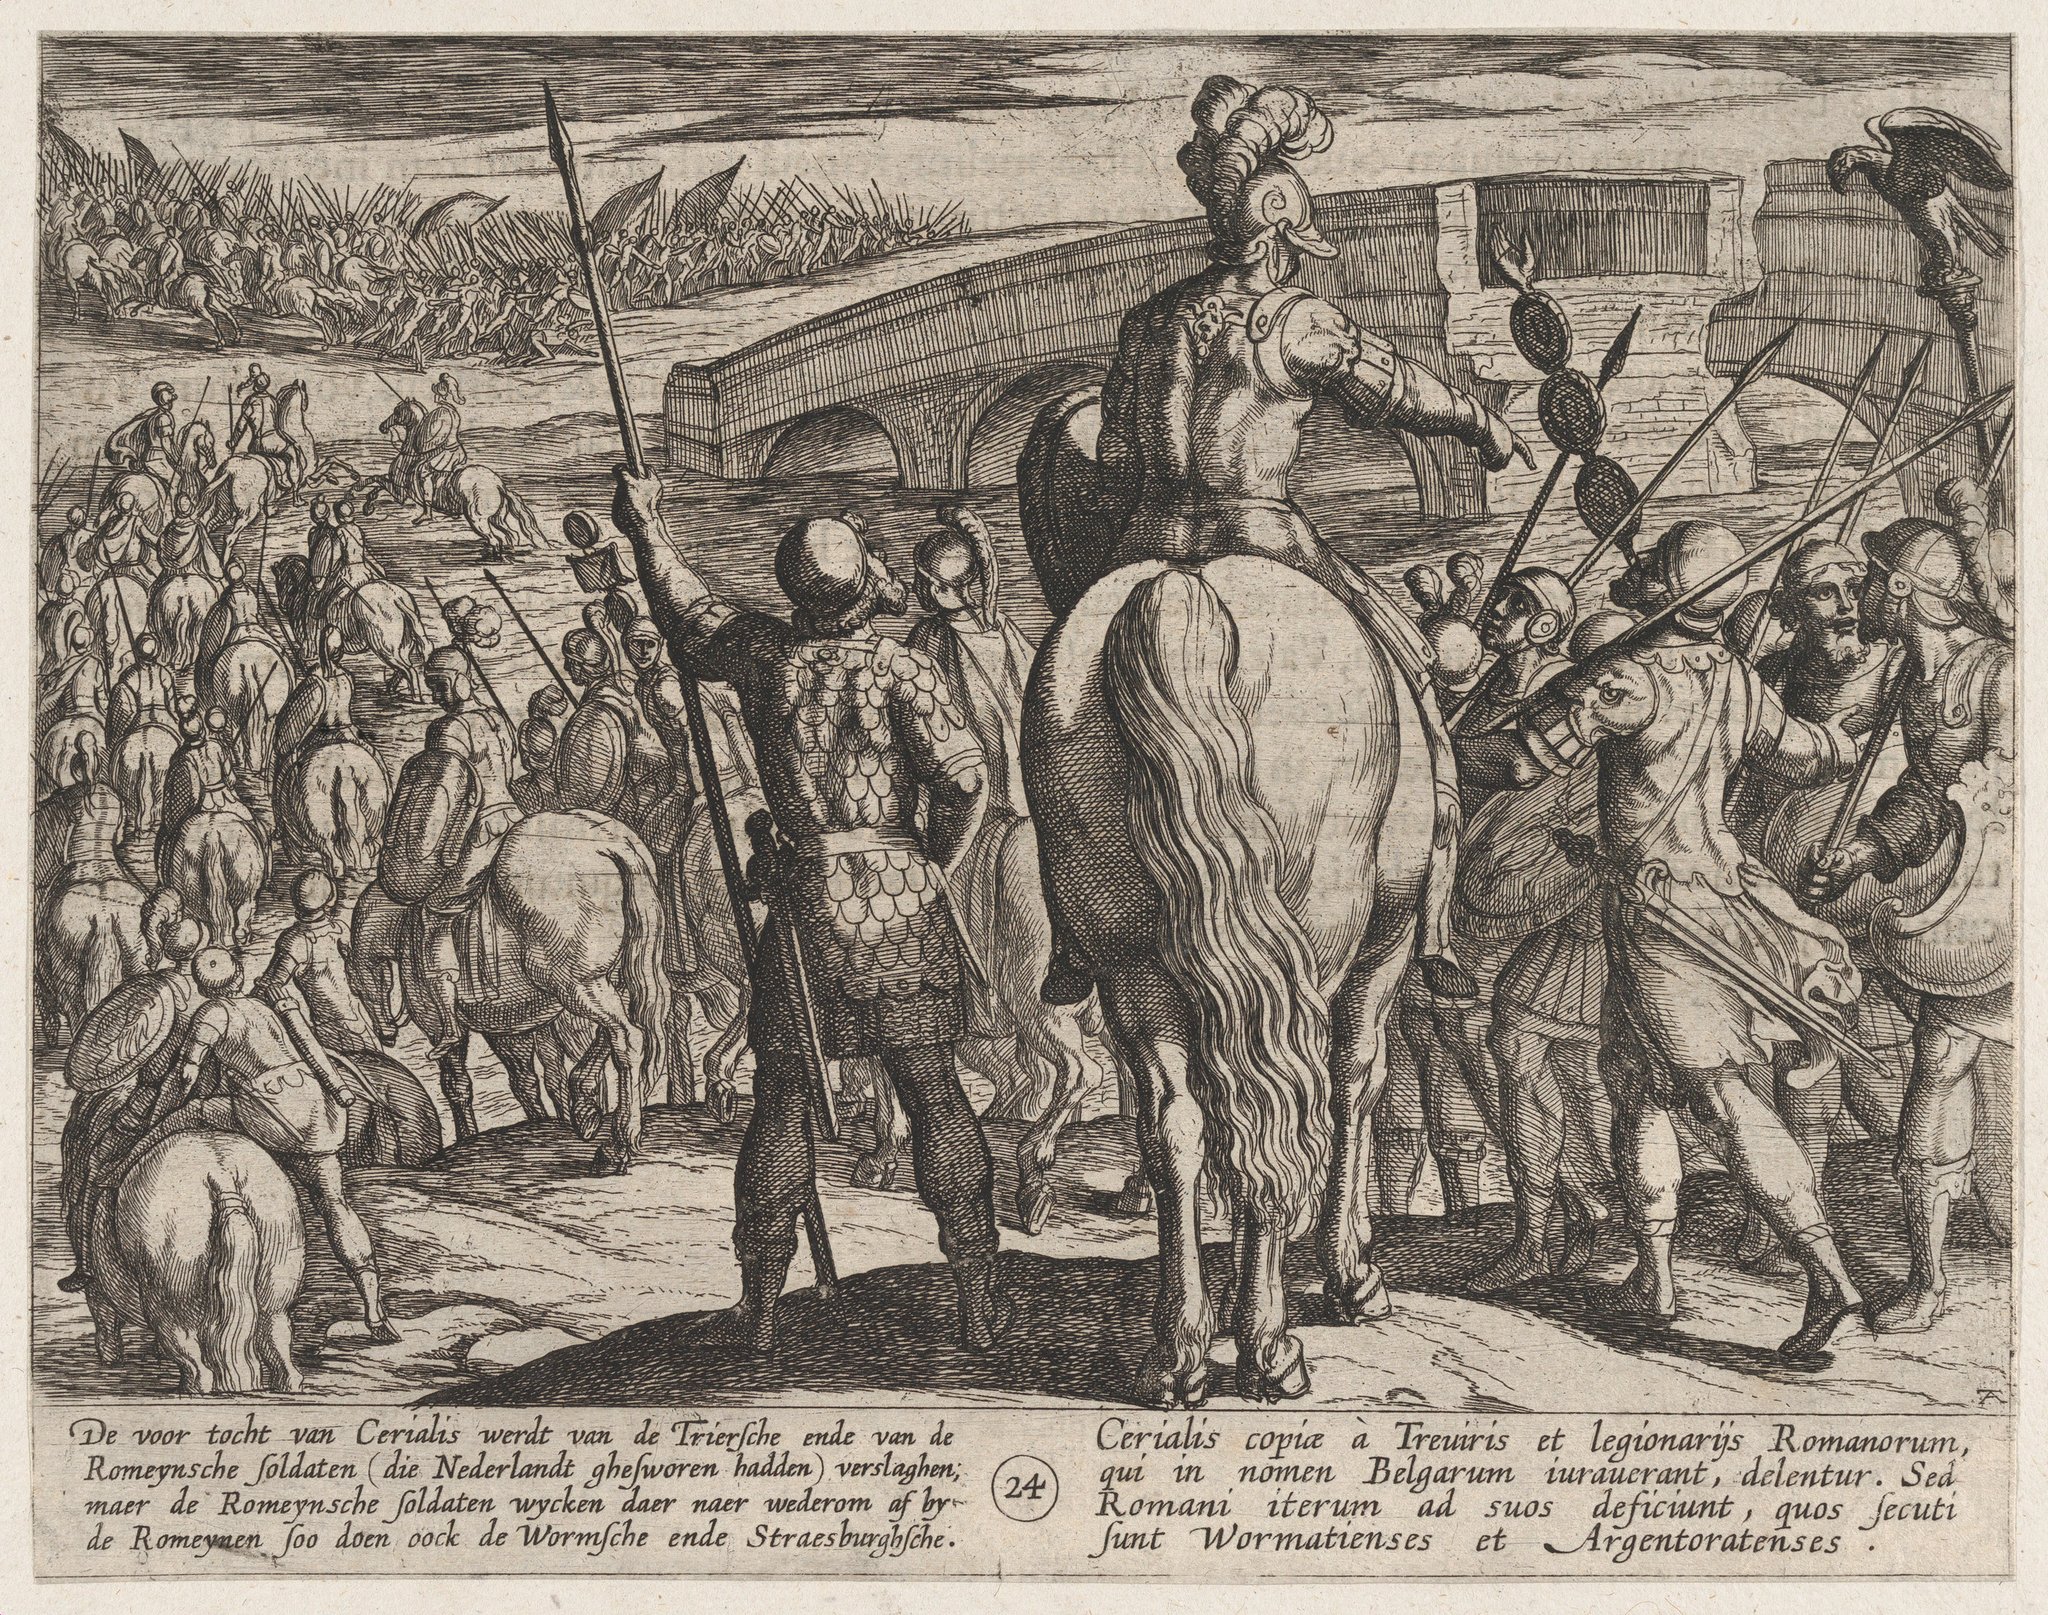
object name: print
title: Plate 24: The Advance Guard of the New Roman Troops Turned Back, from The War of the Romans Against the Batavians (Romanorvm et Batavorvm societas)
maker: antonio tempesta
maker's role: artist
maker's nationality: italian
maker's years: 1555-1630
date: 1611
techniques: etching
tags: bridges,wars,men,horses